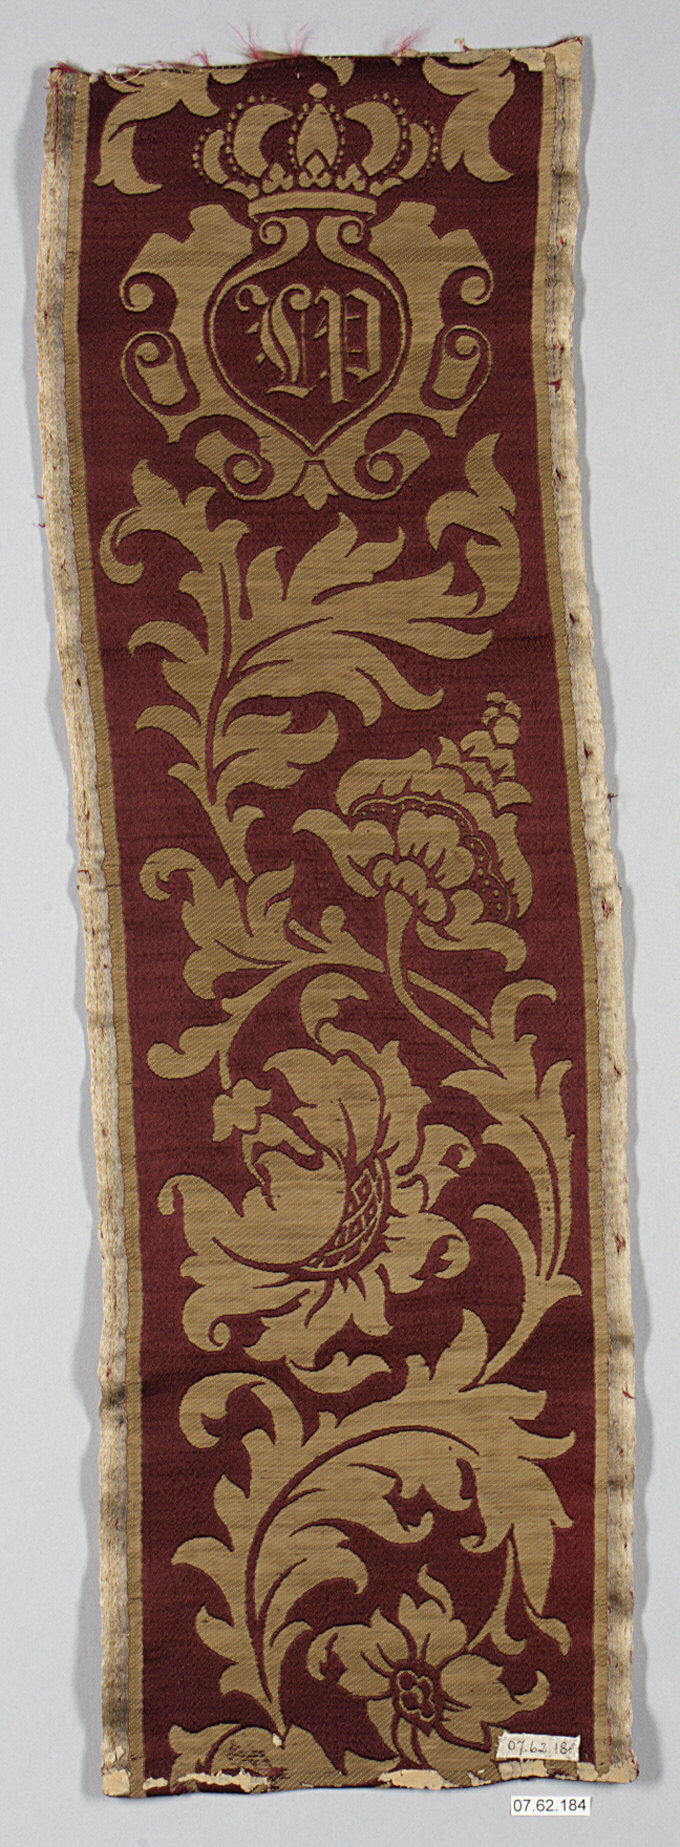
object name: ribbon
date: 1830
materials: metal thread, silk